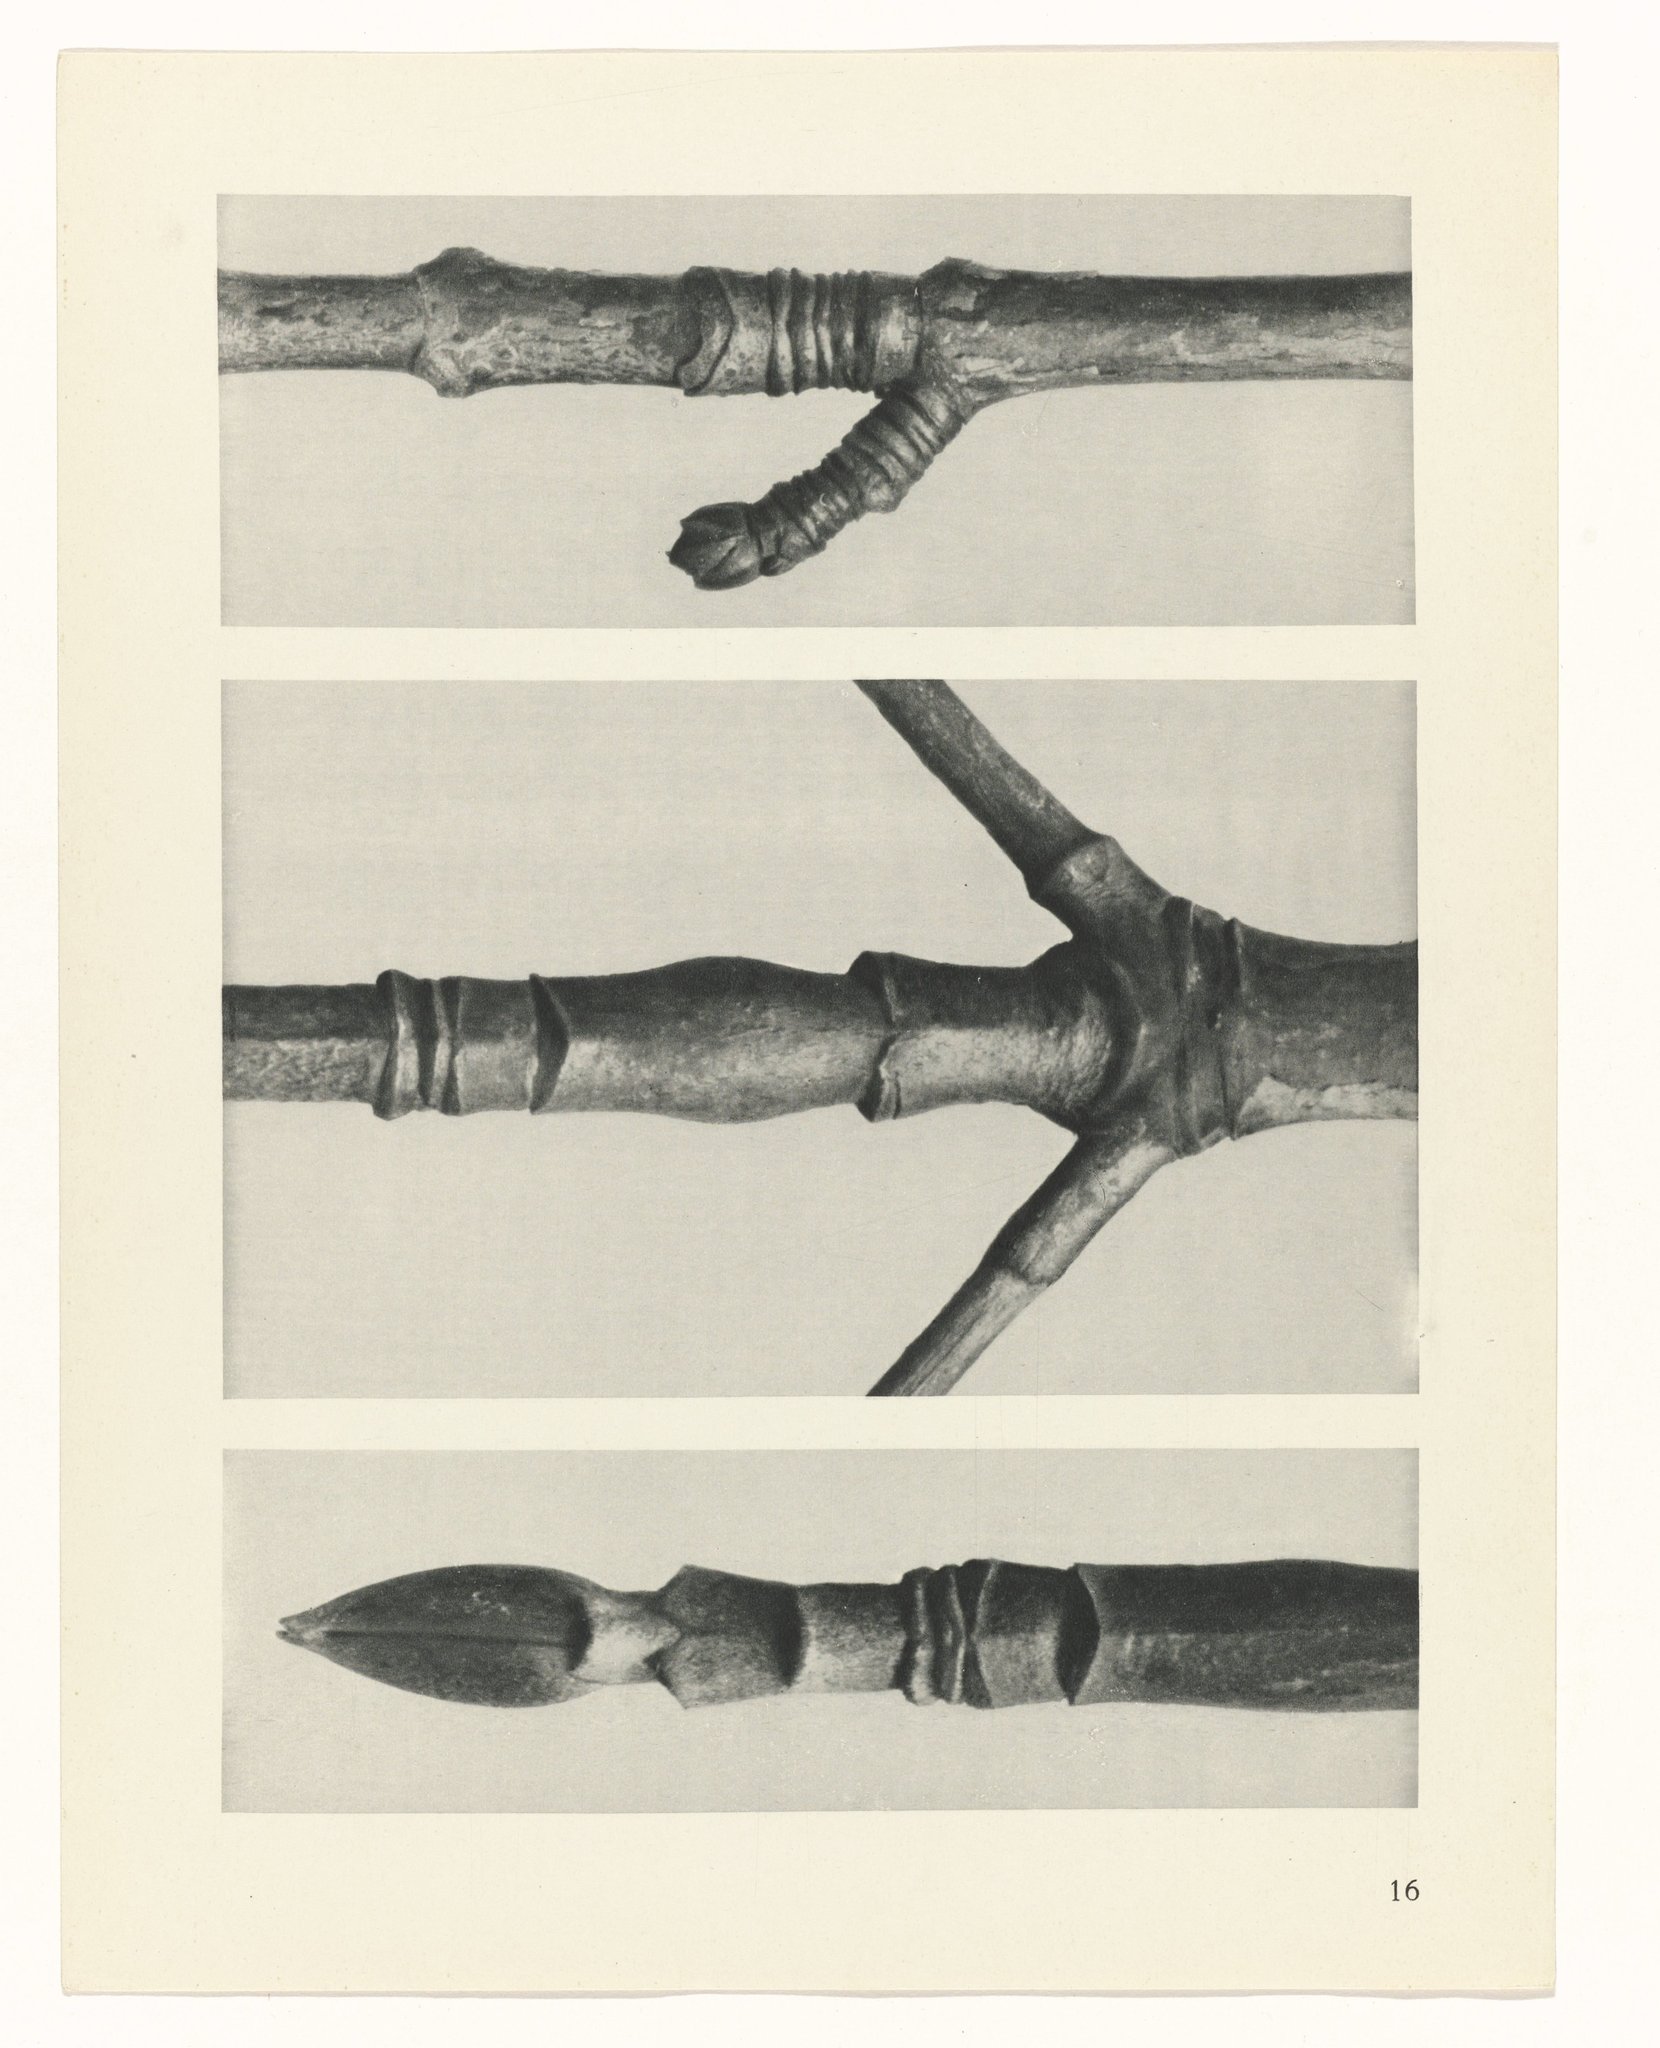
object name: photograph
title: Plantstudie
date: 1928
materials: ink, paper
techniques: rotogravure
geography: berlin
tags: plants (in general)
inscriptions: number: ‘16’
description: facher Vergrößerung. Afkomstig uit losbladige uitgave.